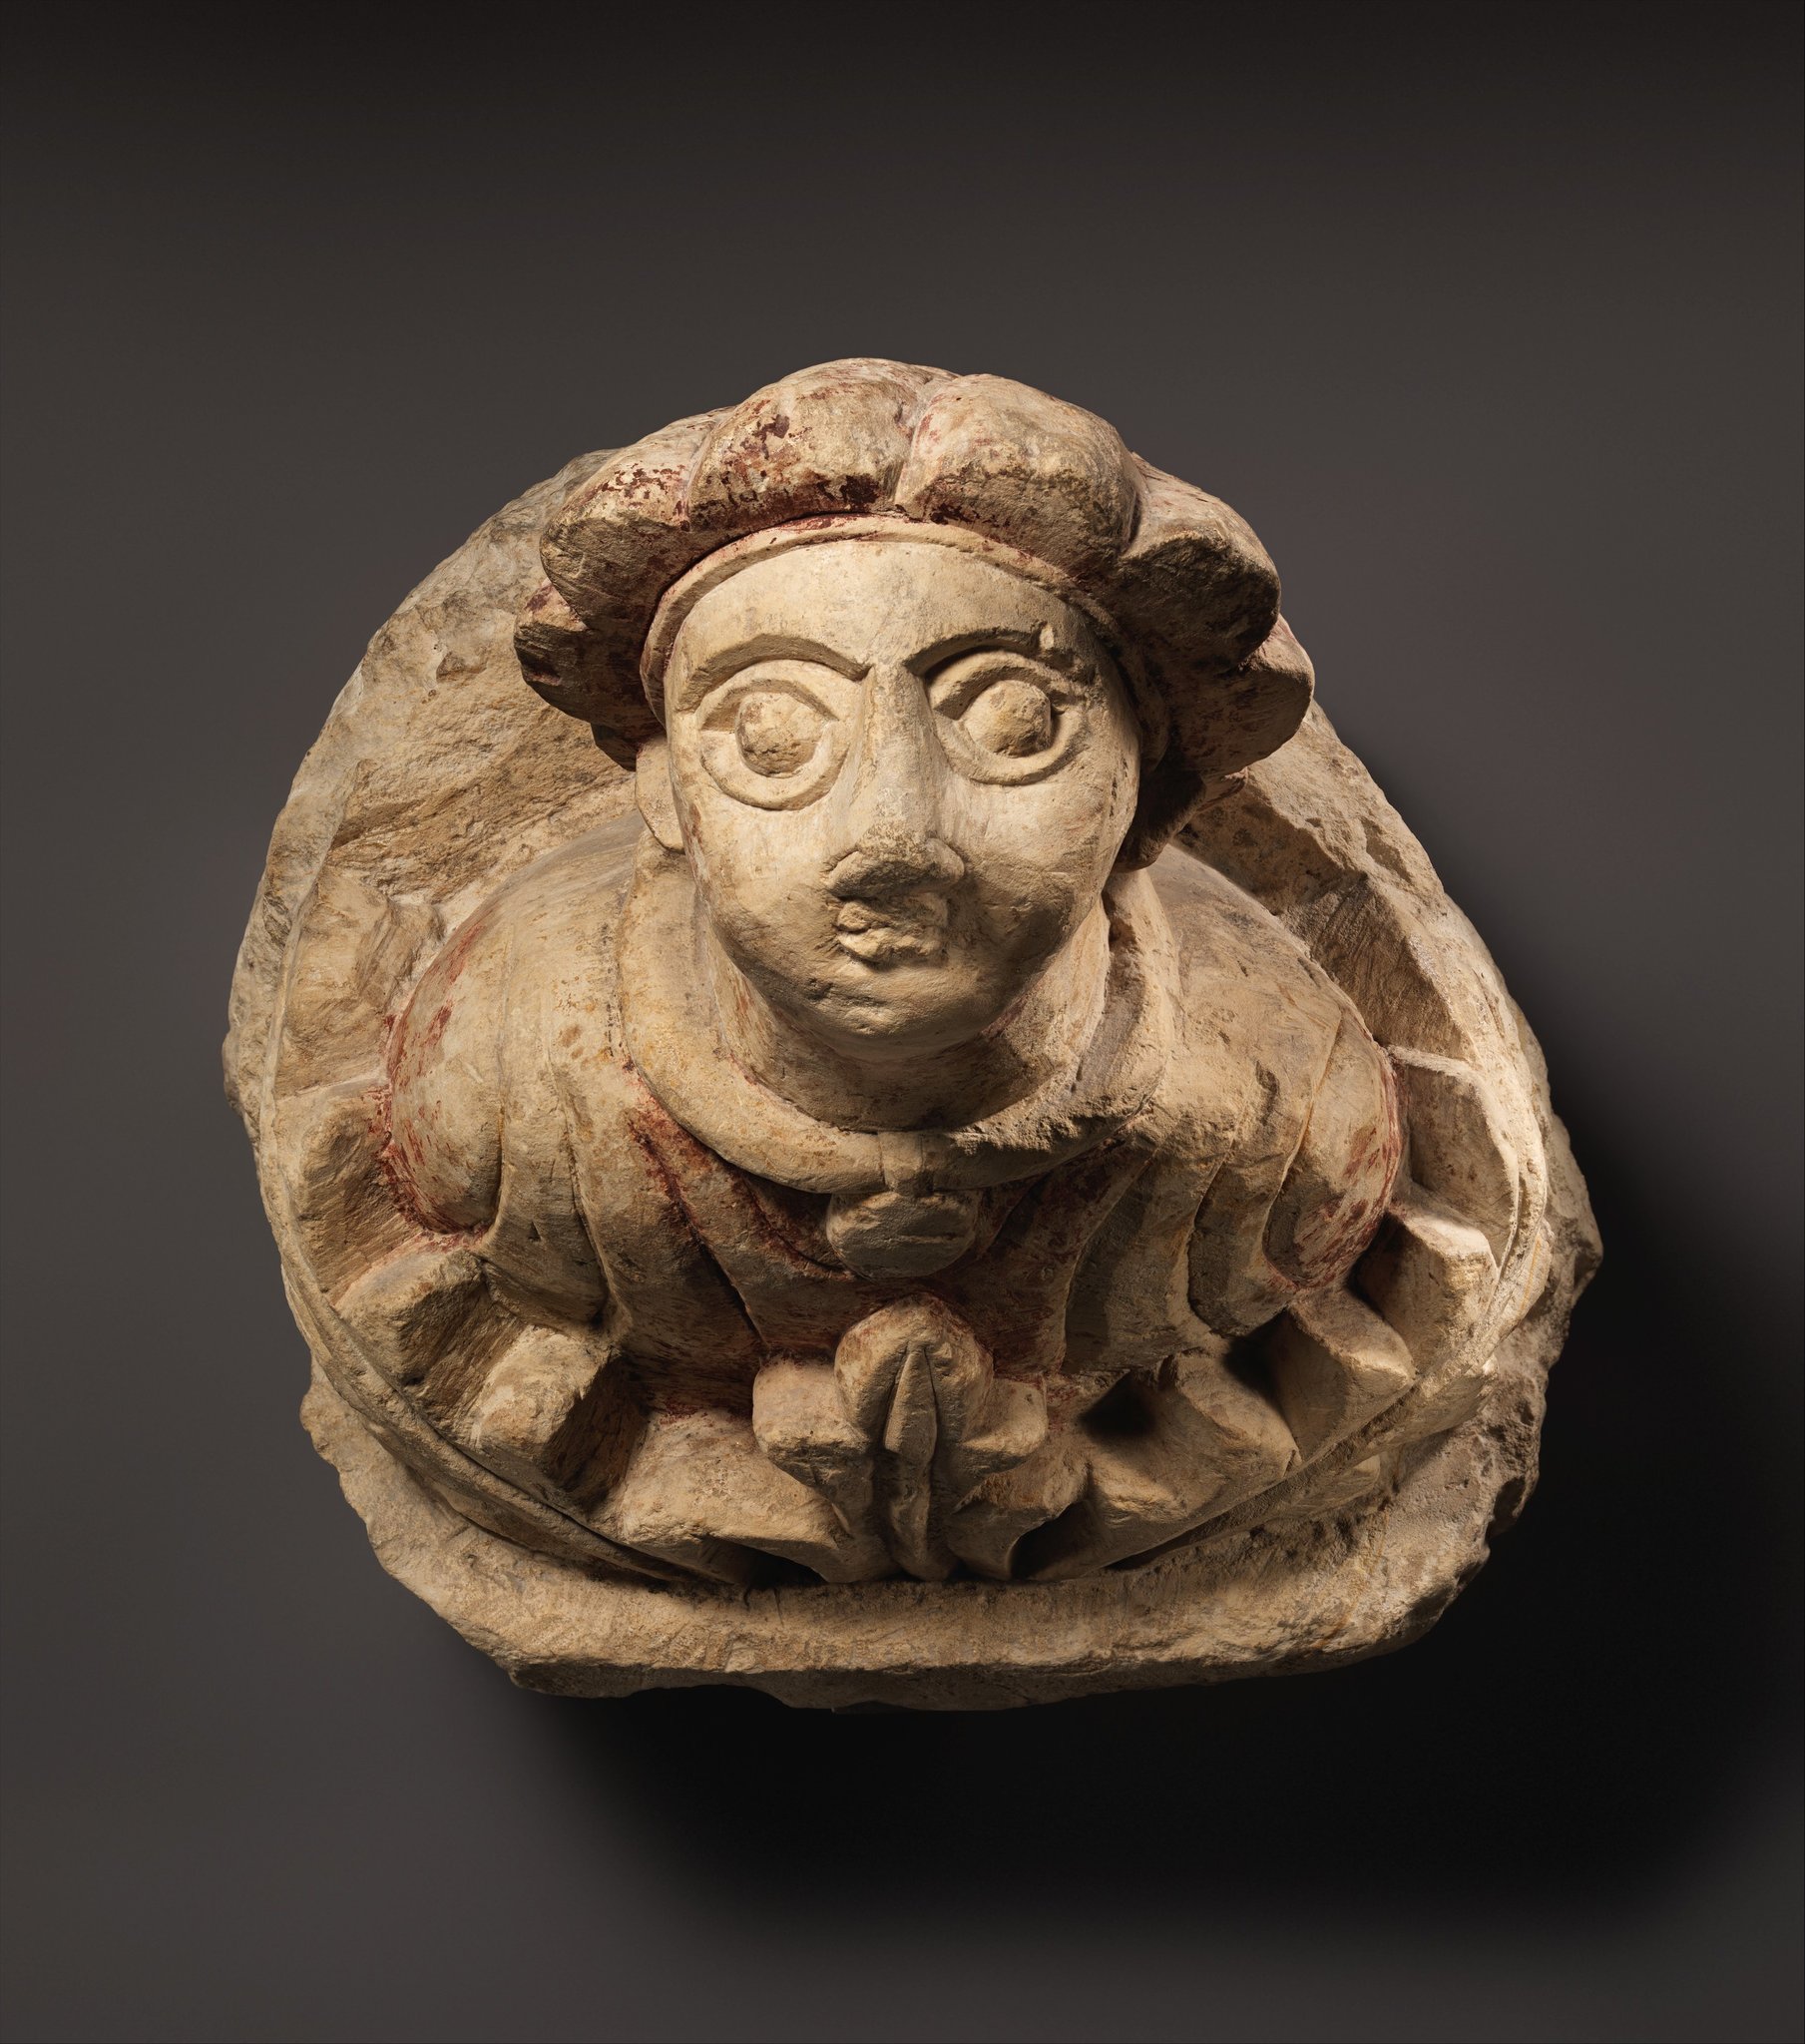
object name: corbel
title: Corbel with Human Bust and Acanthus Leaves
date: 401-600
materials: limestone, paint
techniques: carving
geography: egypt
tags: human figures,faces,acanthus